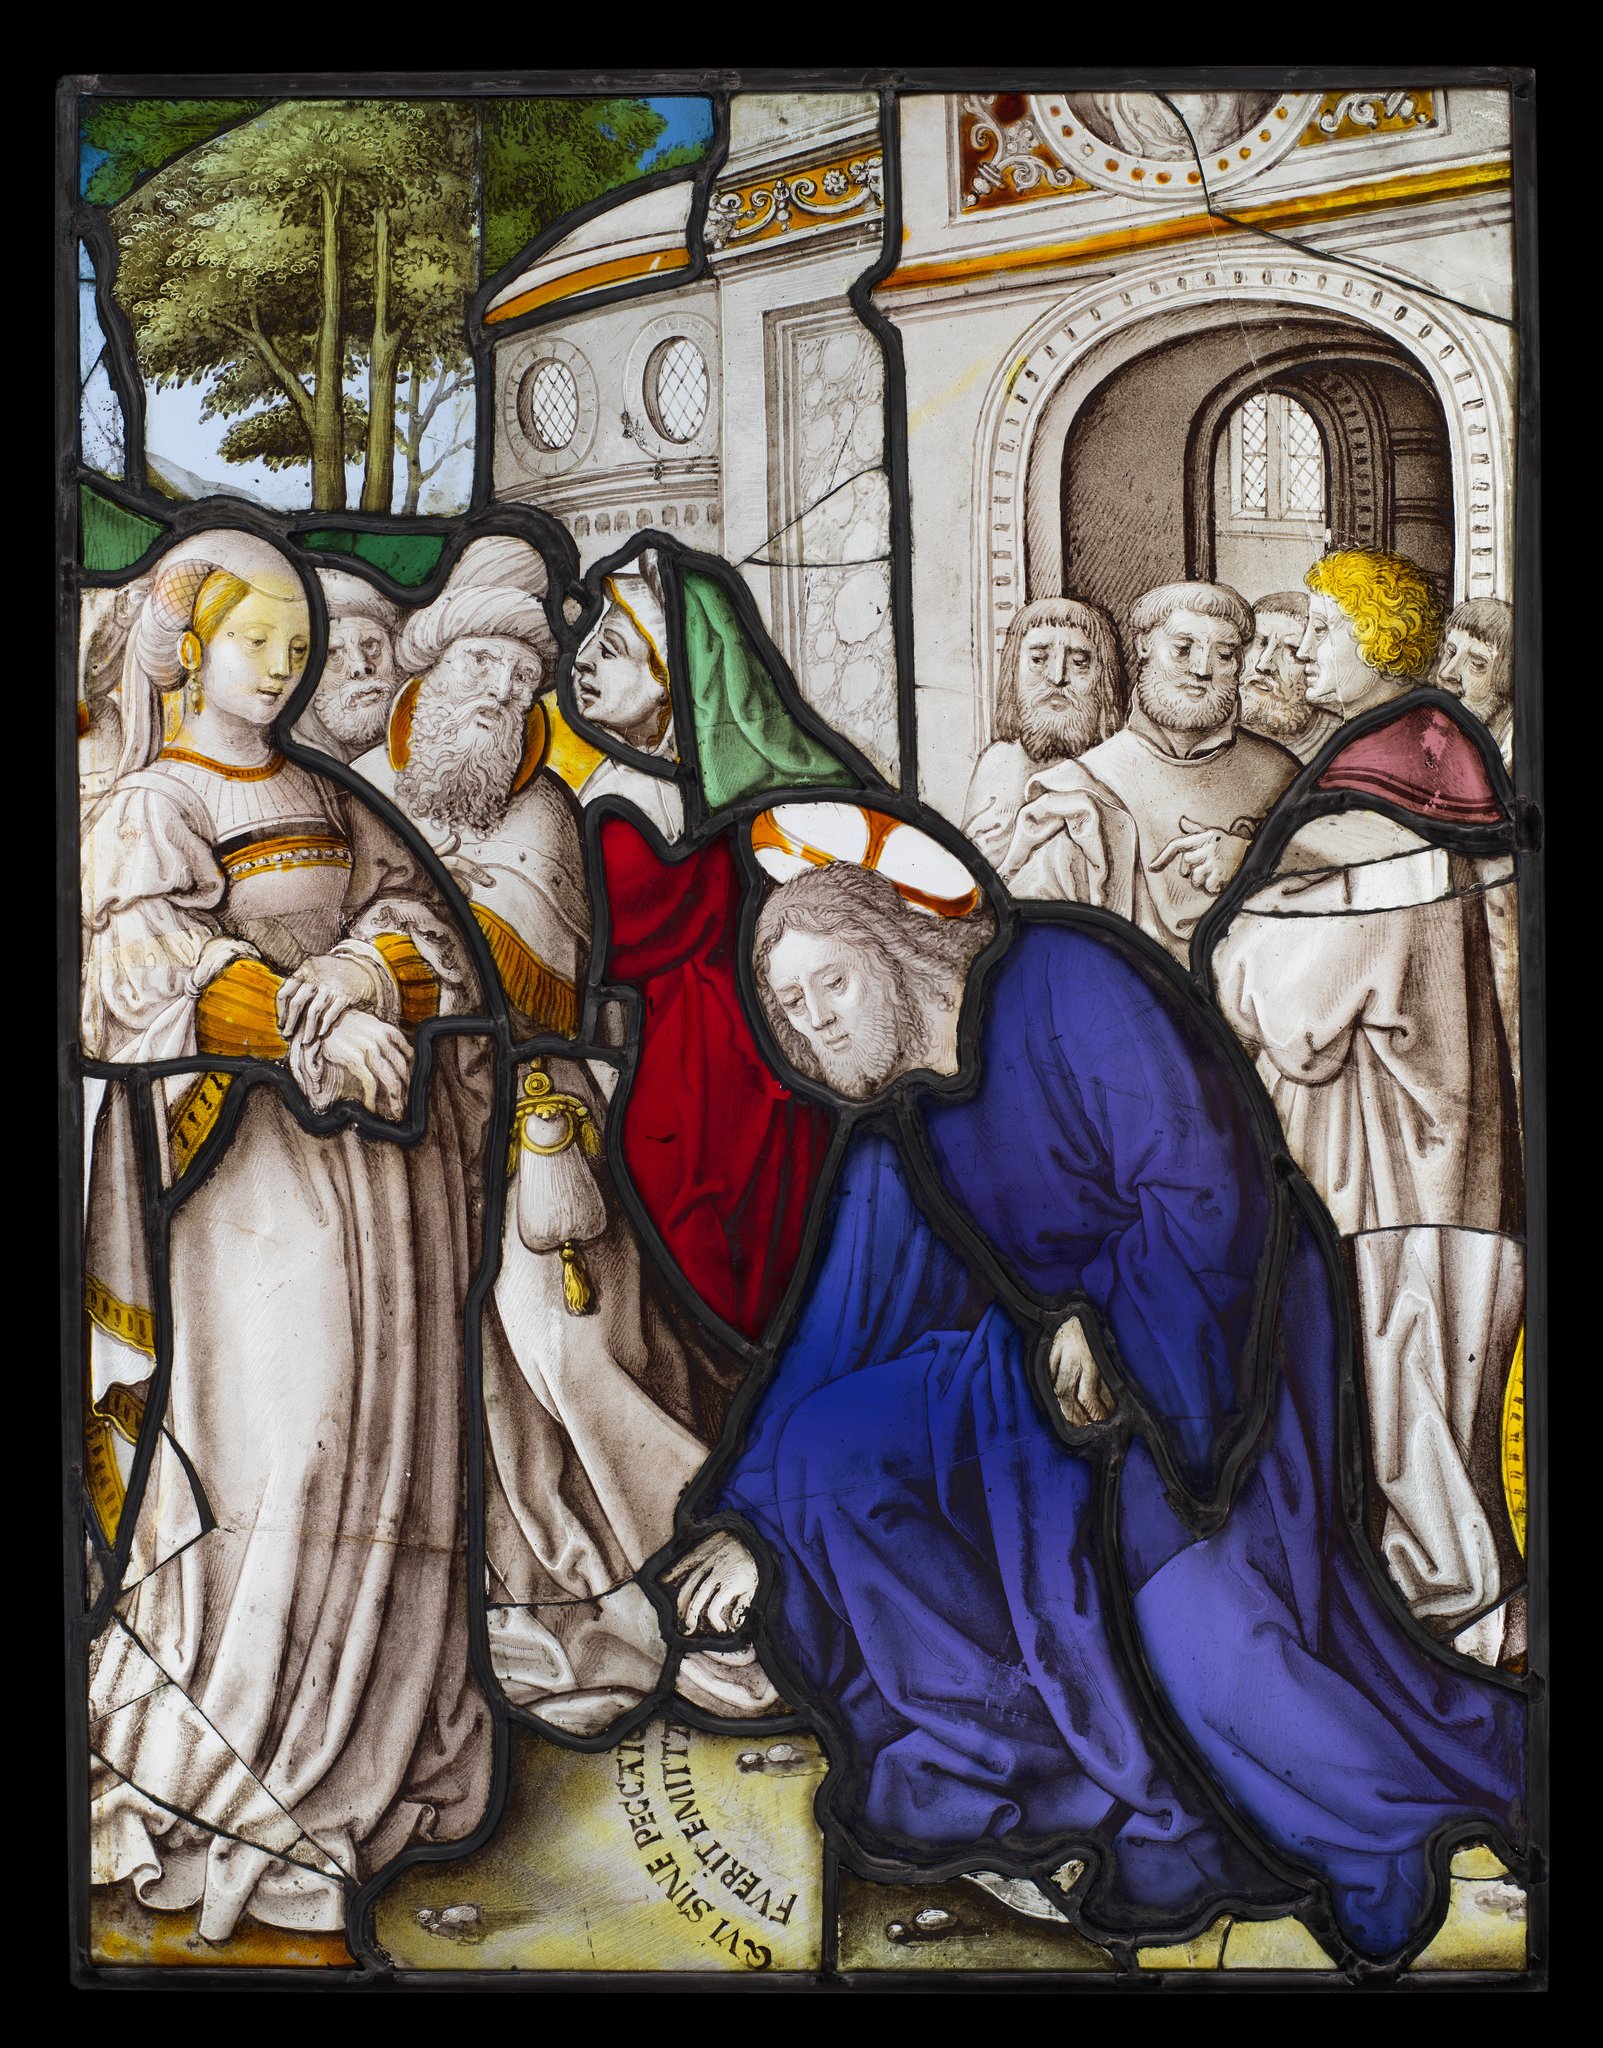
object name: panel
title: Christ and the Woman Taken in Adultery (one of a set of 12 scenes from The Life of Christ)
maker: jan rombouts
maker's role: maker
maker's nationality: south netherlandish (duchy of brabant)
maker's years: 1475-1535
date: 1525-1530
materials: glass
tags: men,women,christ